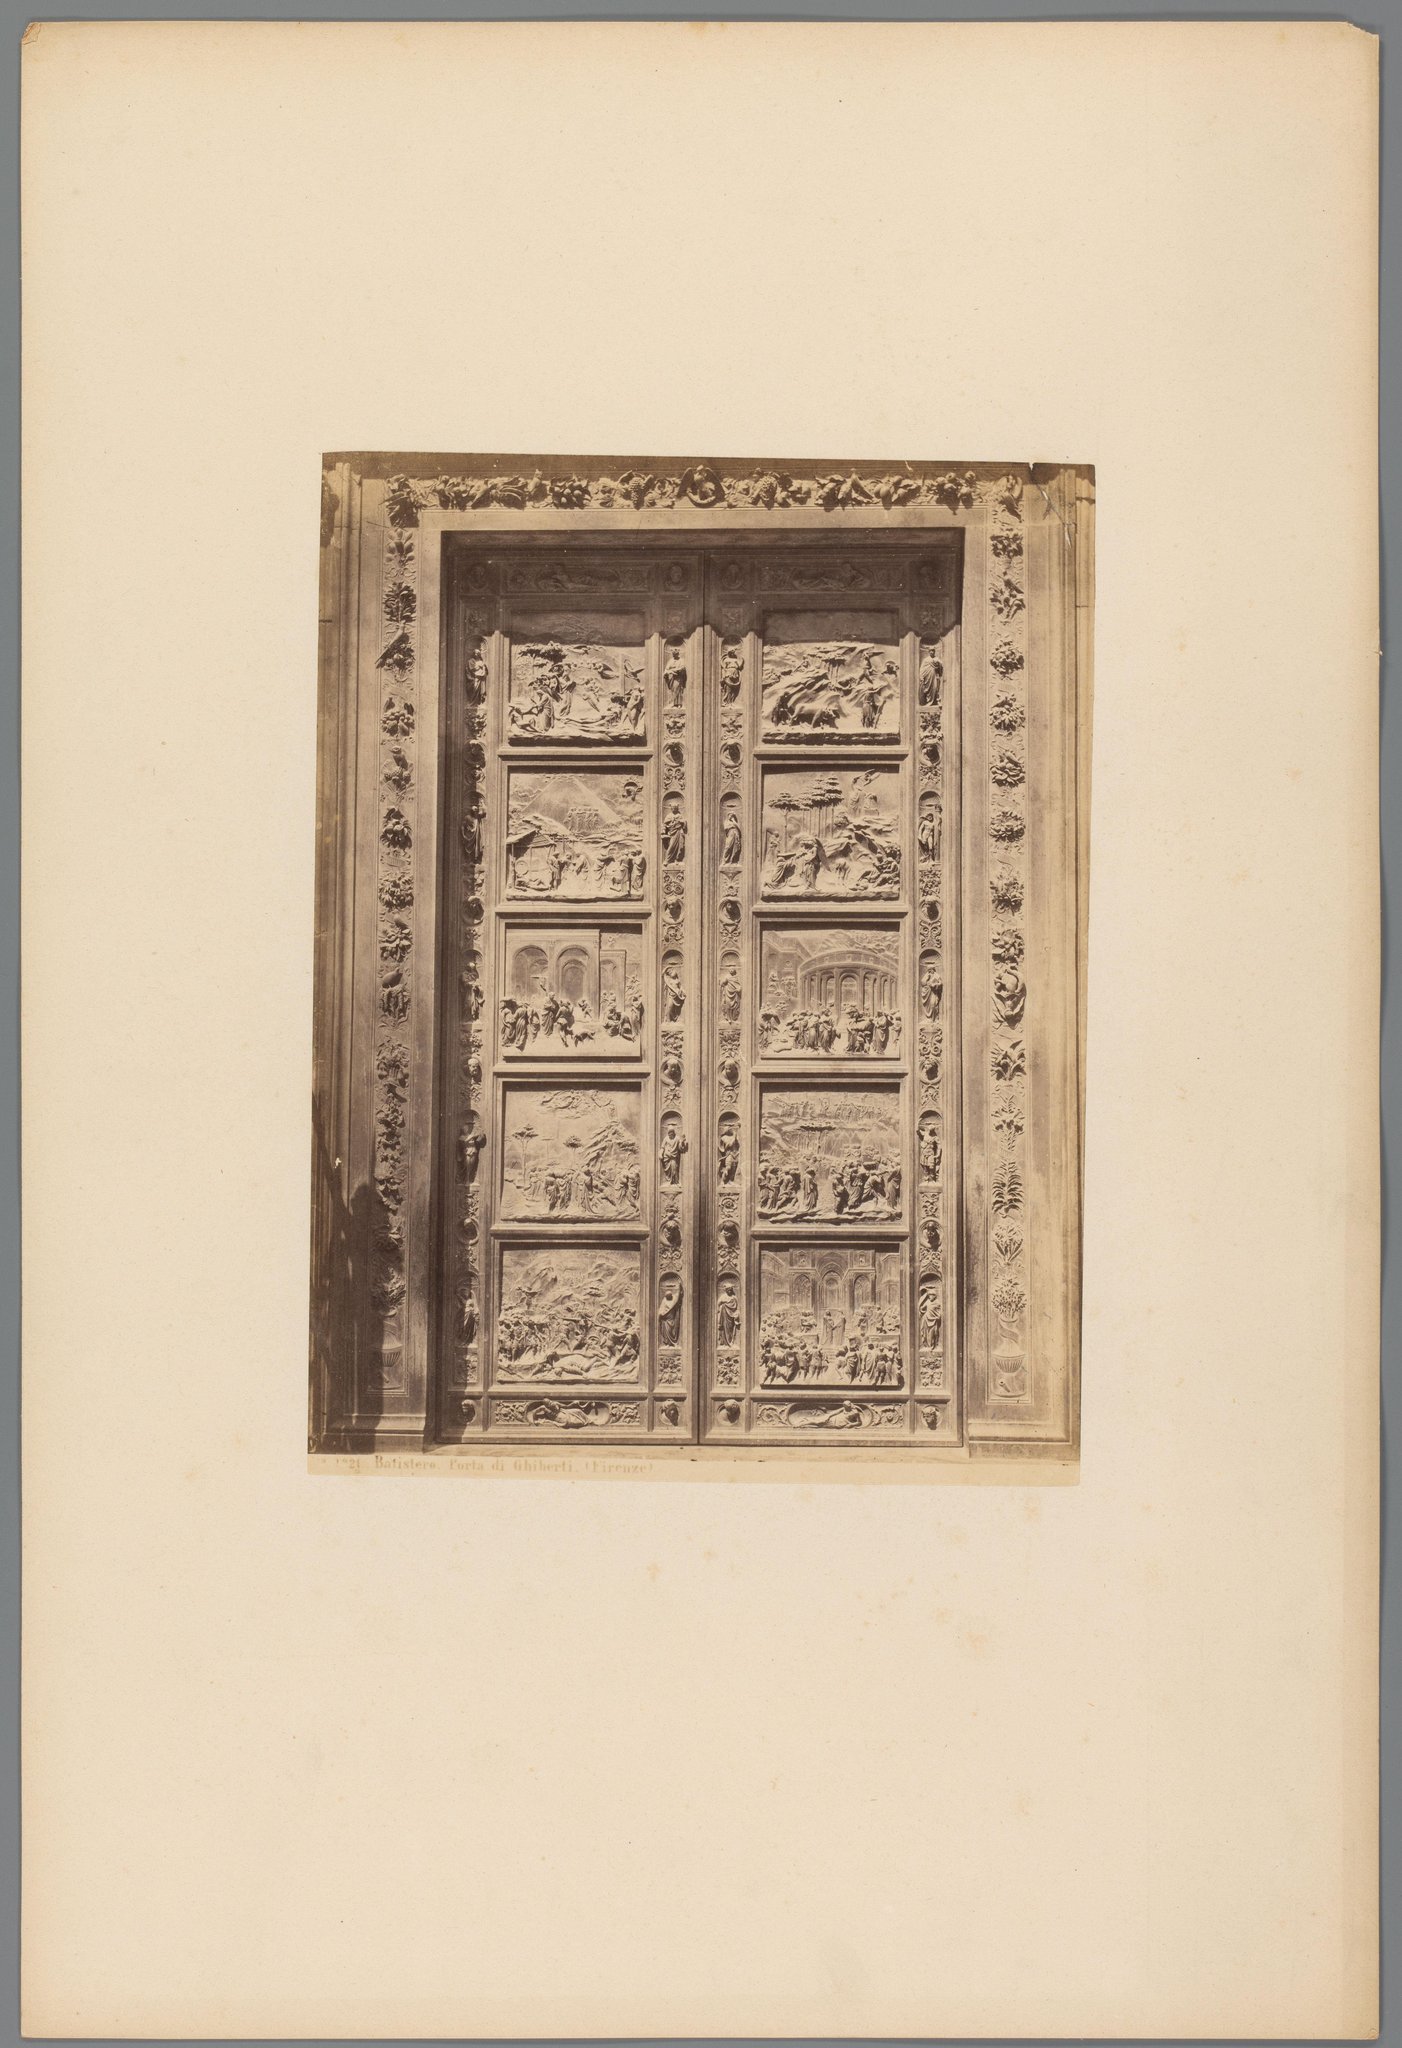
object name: photograph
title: Bronzen deur van het Baptisterium van Florence naar Lorenzo Ghiberti, Italië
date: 1851-1900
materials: cardboard, paper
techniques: albumen print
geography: florence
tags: door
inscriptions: number: ‘No. 21’